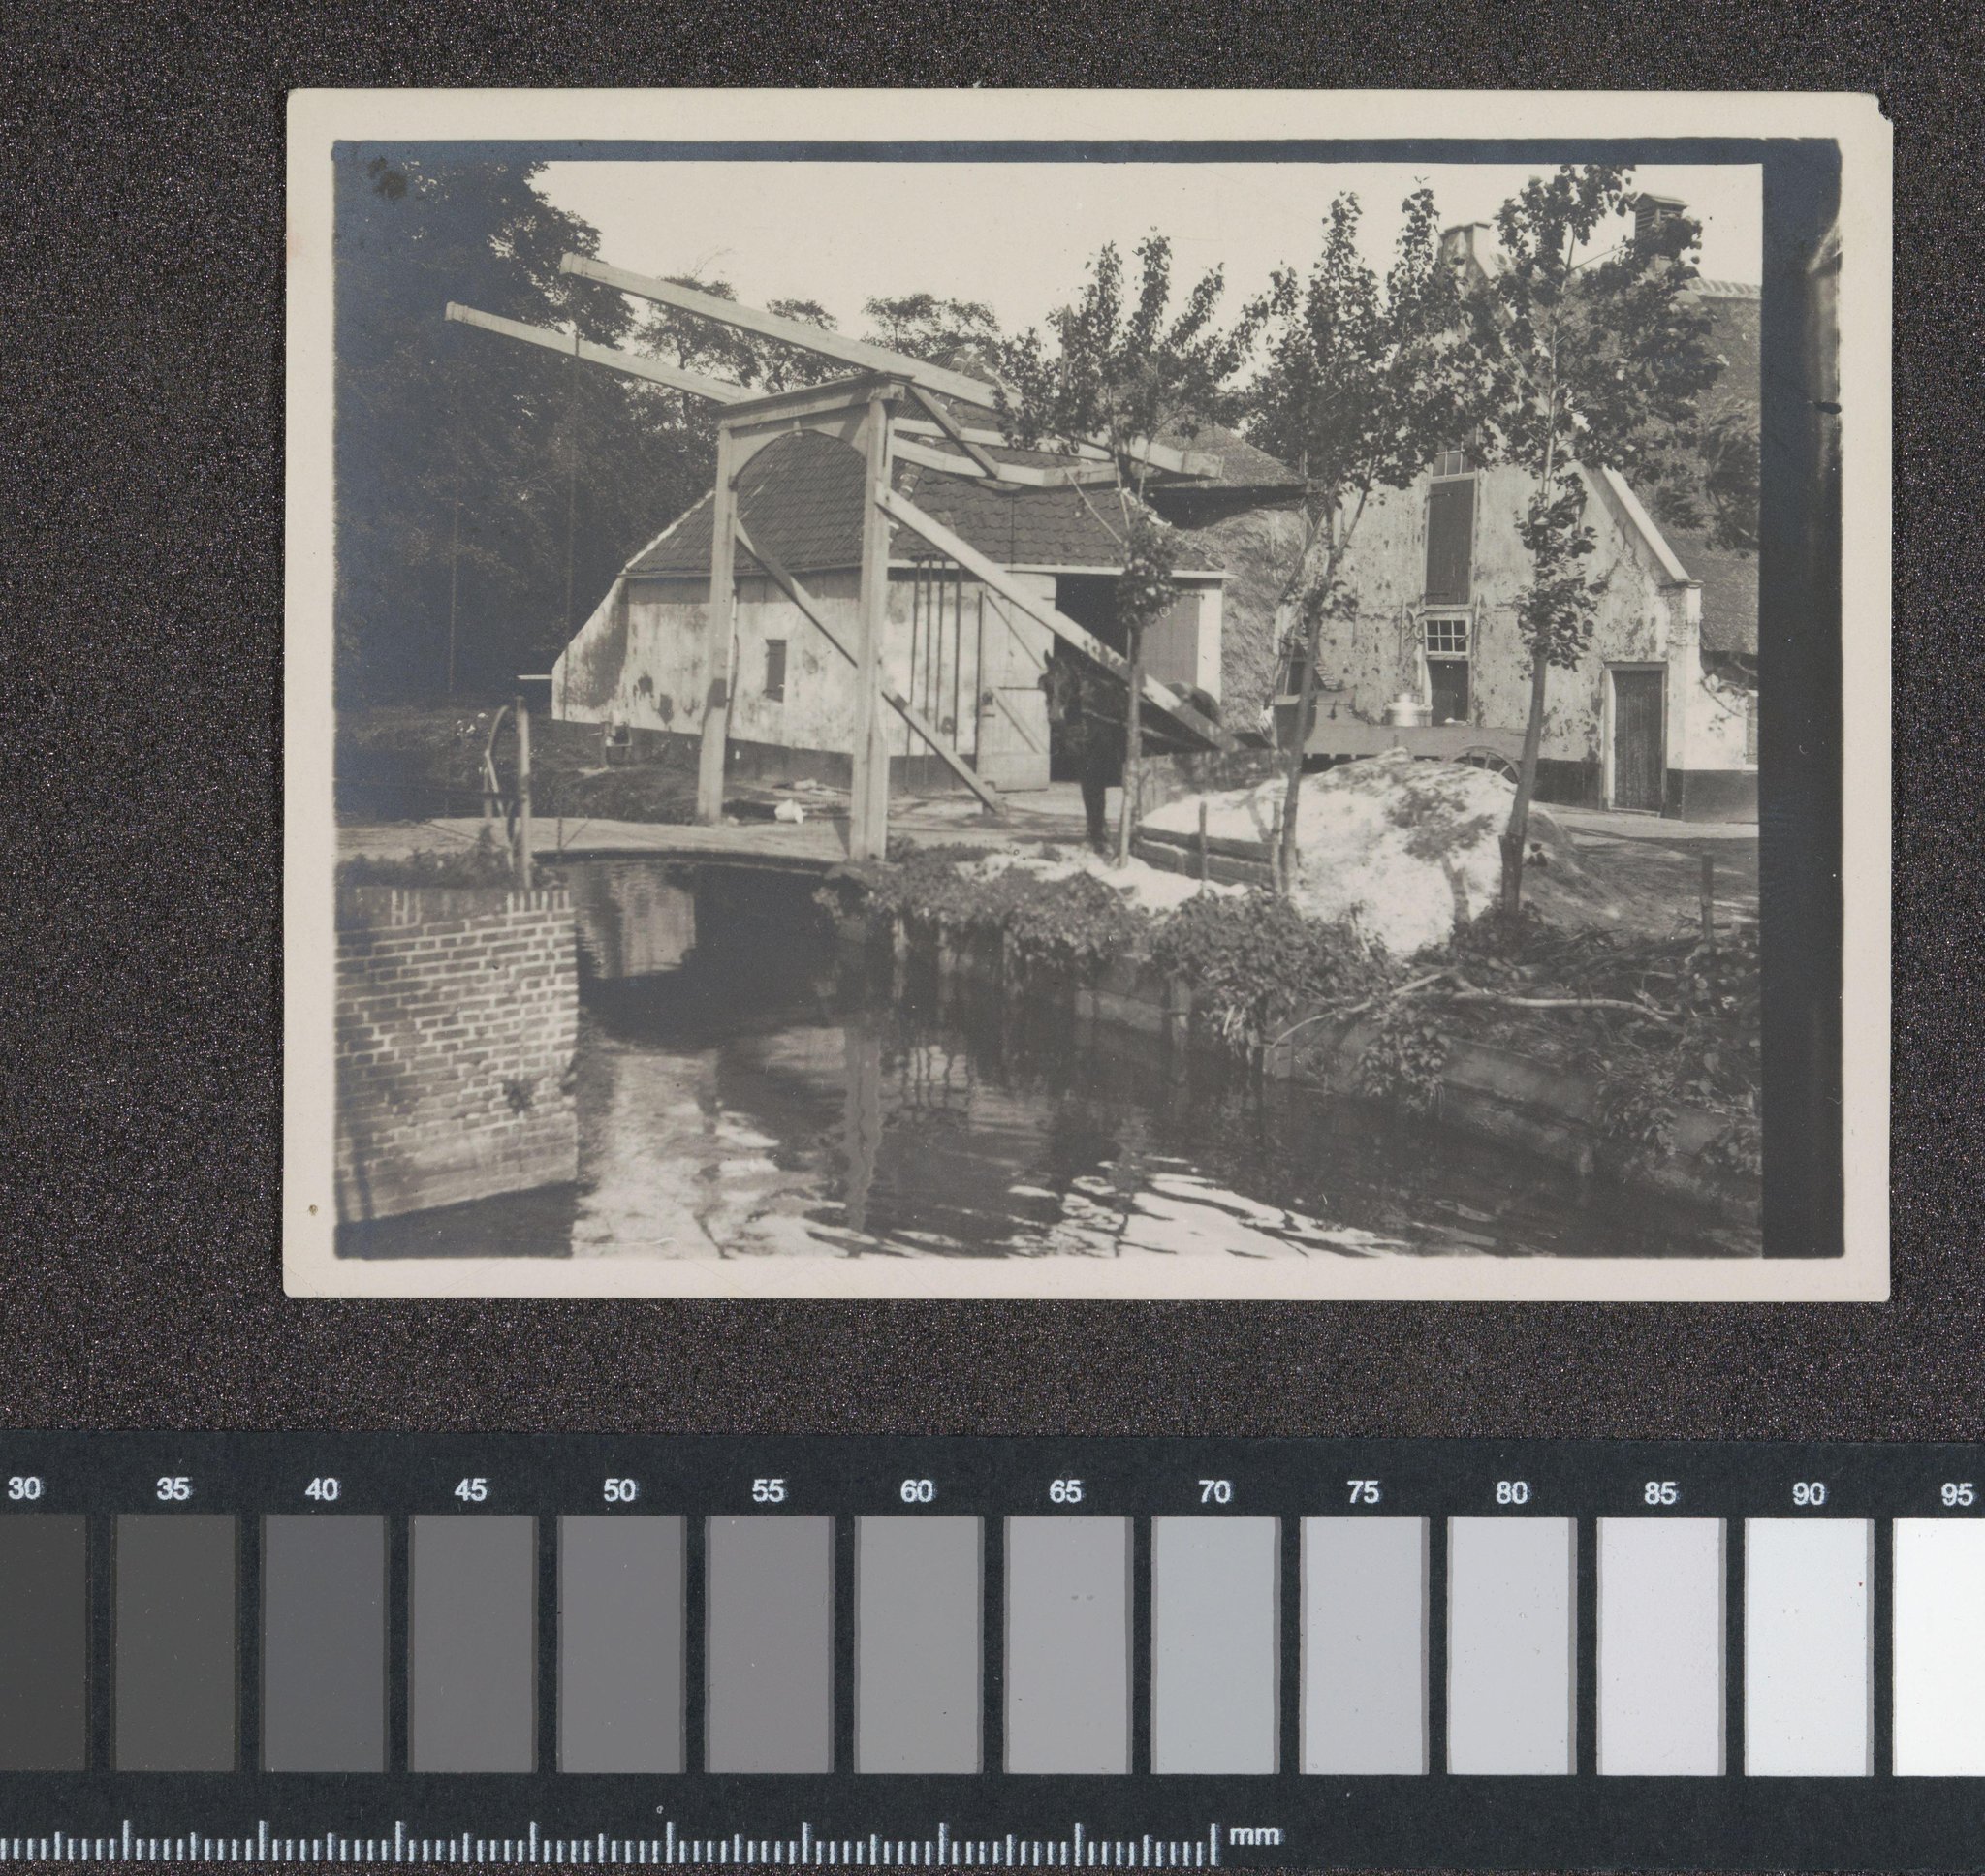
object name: photograph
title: Bij Voorburg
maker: h.c. wilkens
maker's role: amateurfotograaf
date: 1915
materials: photographic support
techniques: gelatin silver print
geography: voorburg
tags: bridge